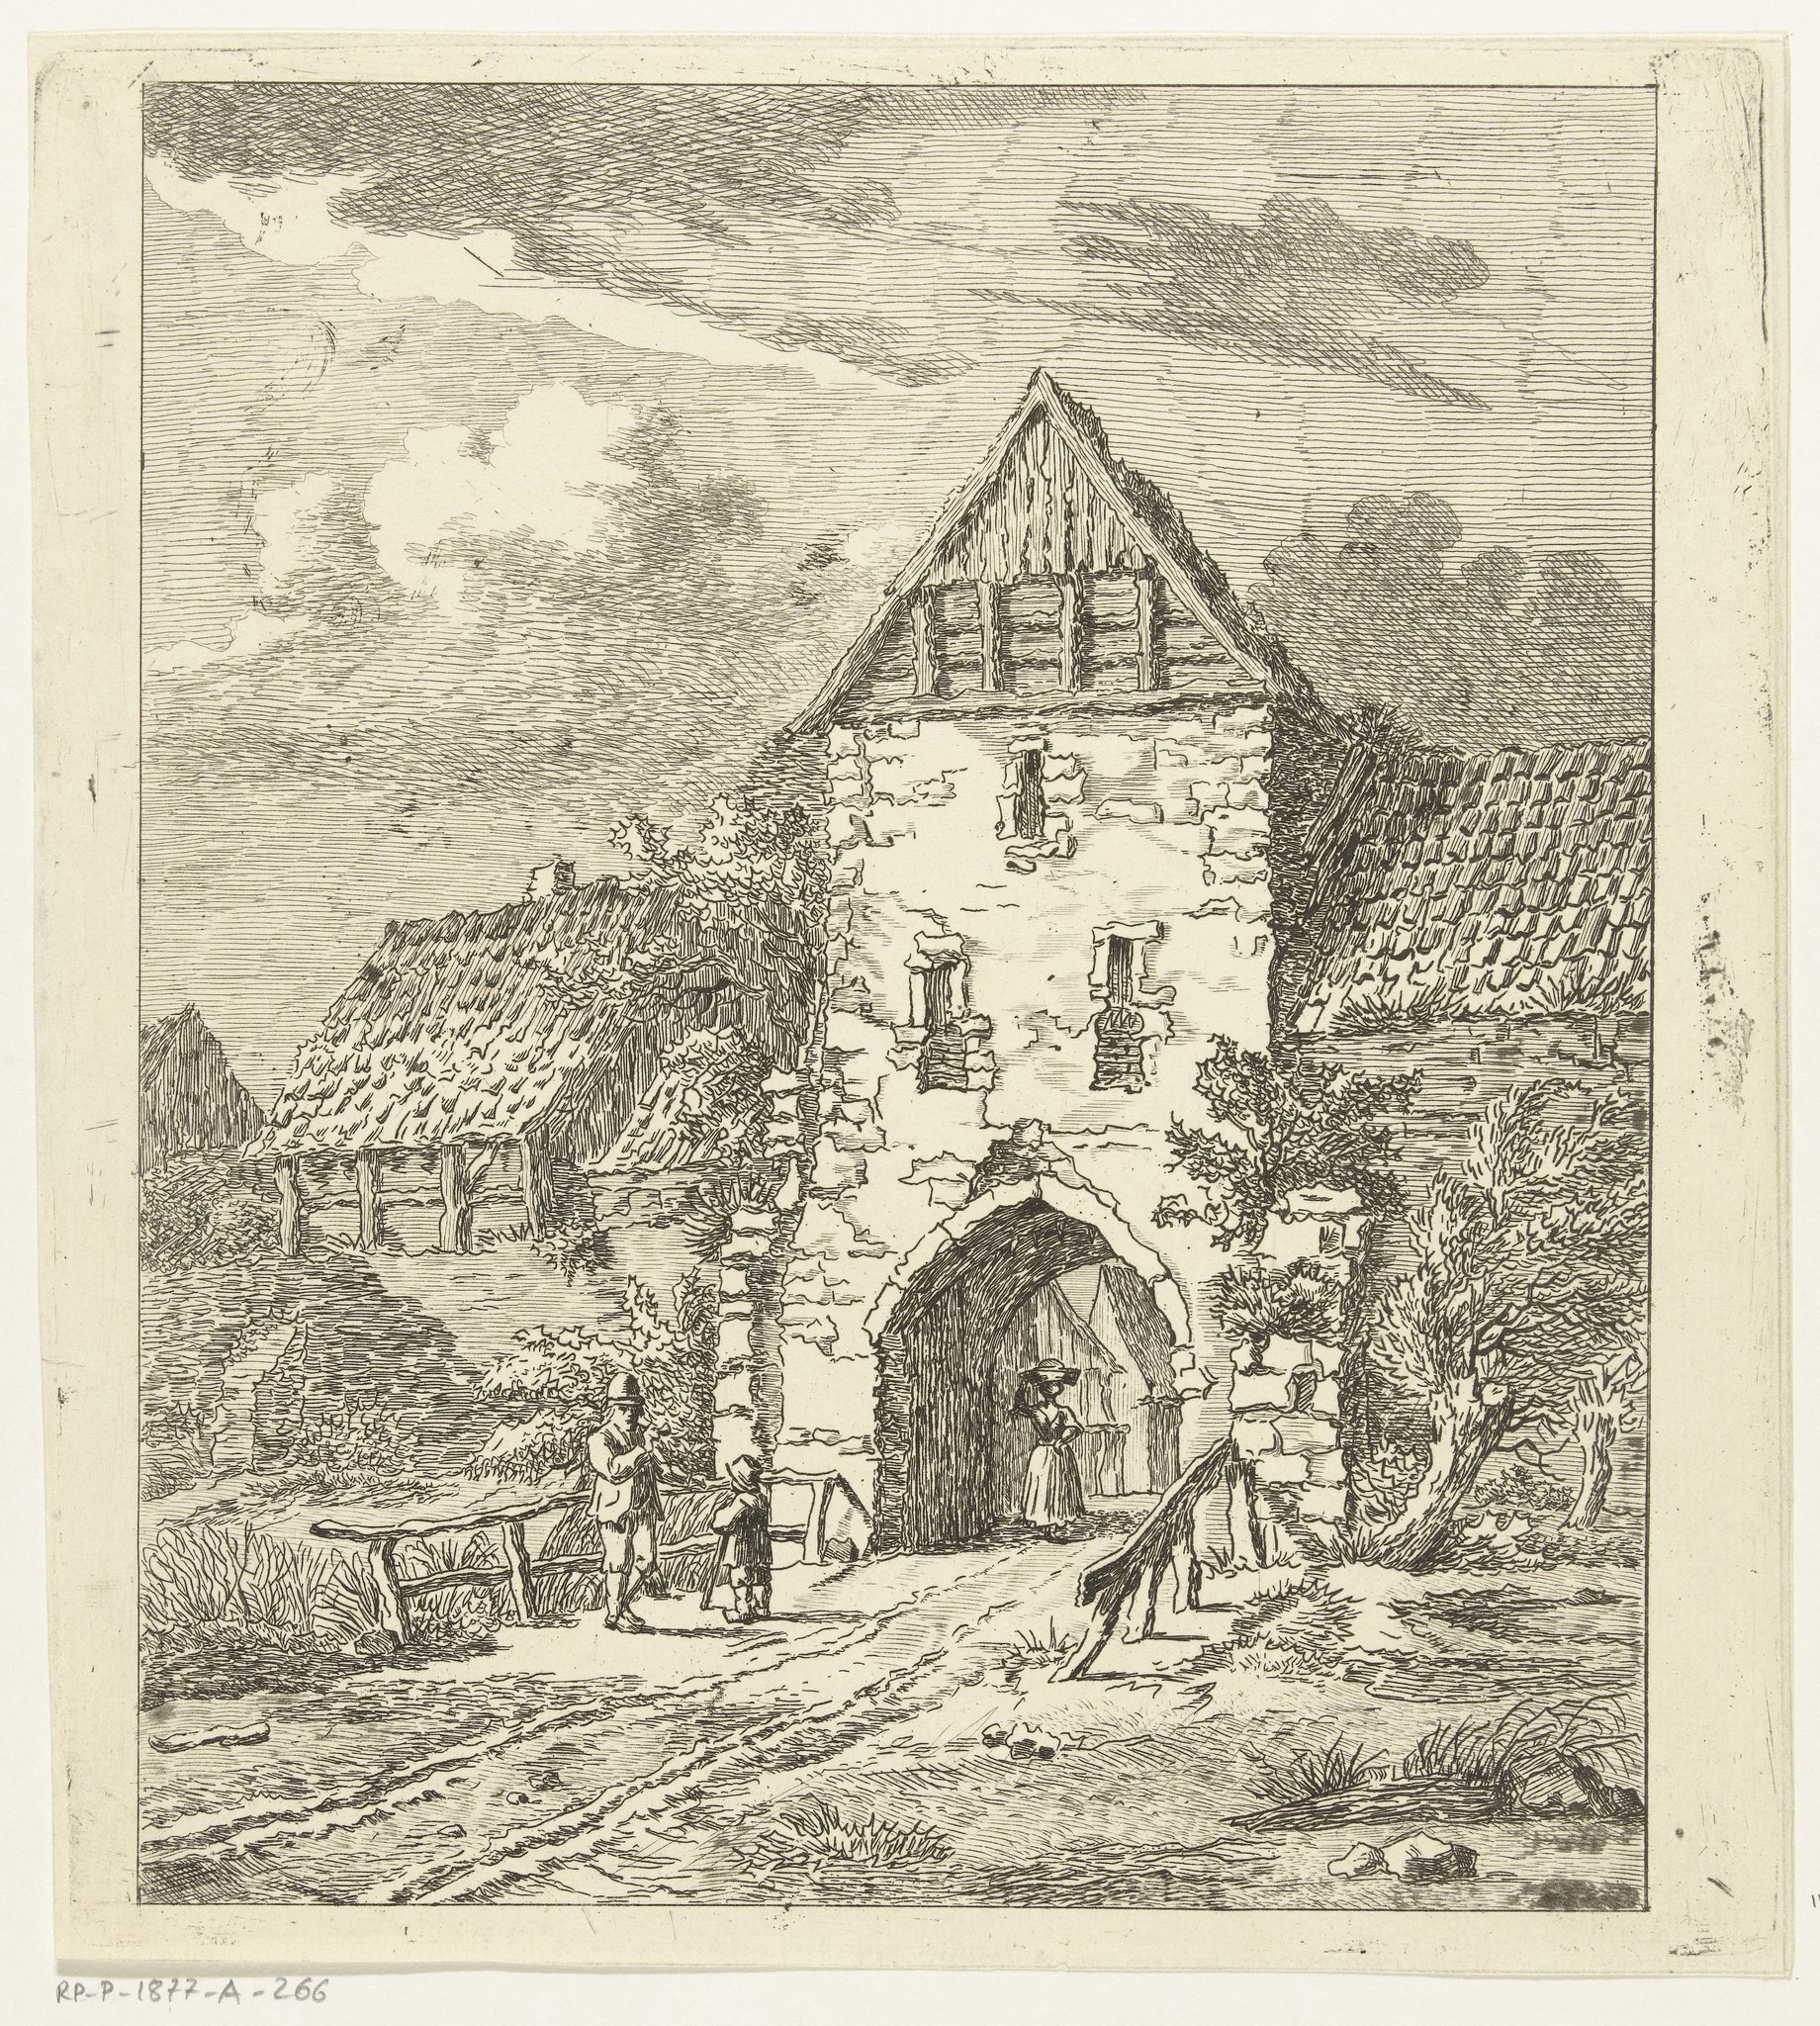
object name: print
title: Enkele figuren bij een oude stadspoort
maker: anthonie van den bos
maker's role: draughtsman, print maker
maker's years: 1763-1838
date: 1778-1838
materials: paper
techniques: drypoint, etching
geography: netherlands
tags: pipe ~ tobacco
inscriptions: collector's mark: Lugt 2228